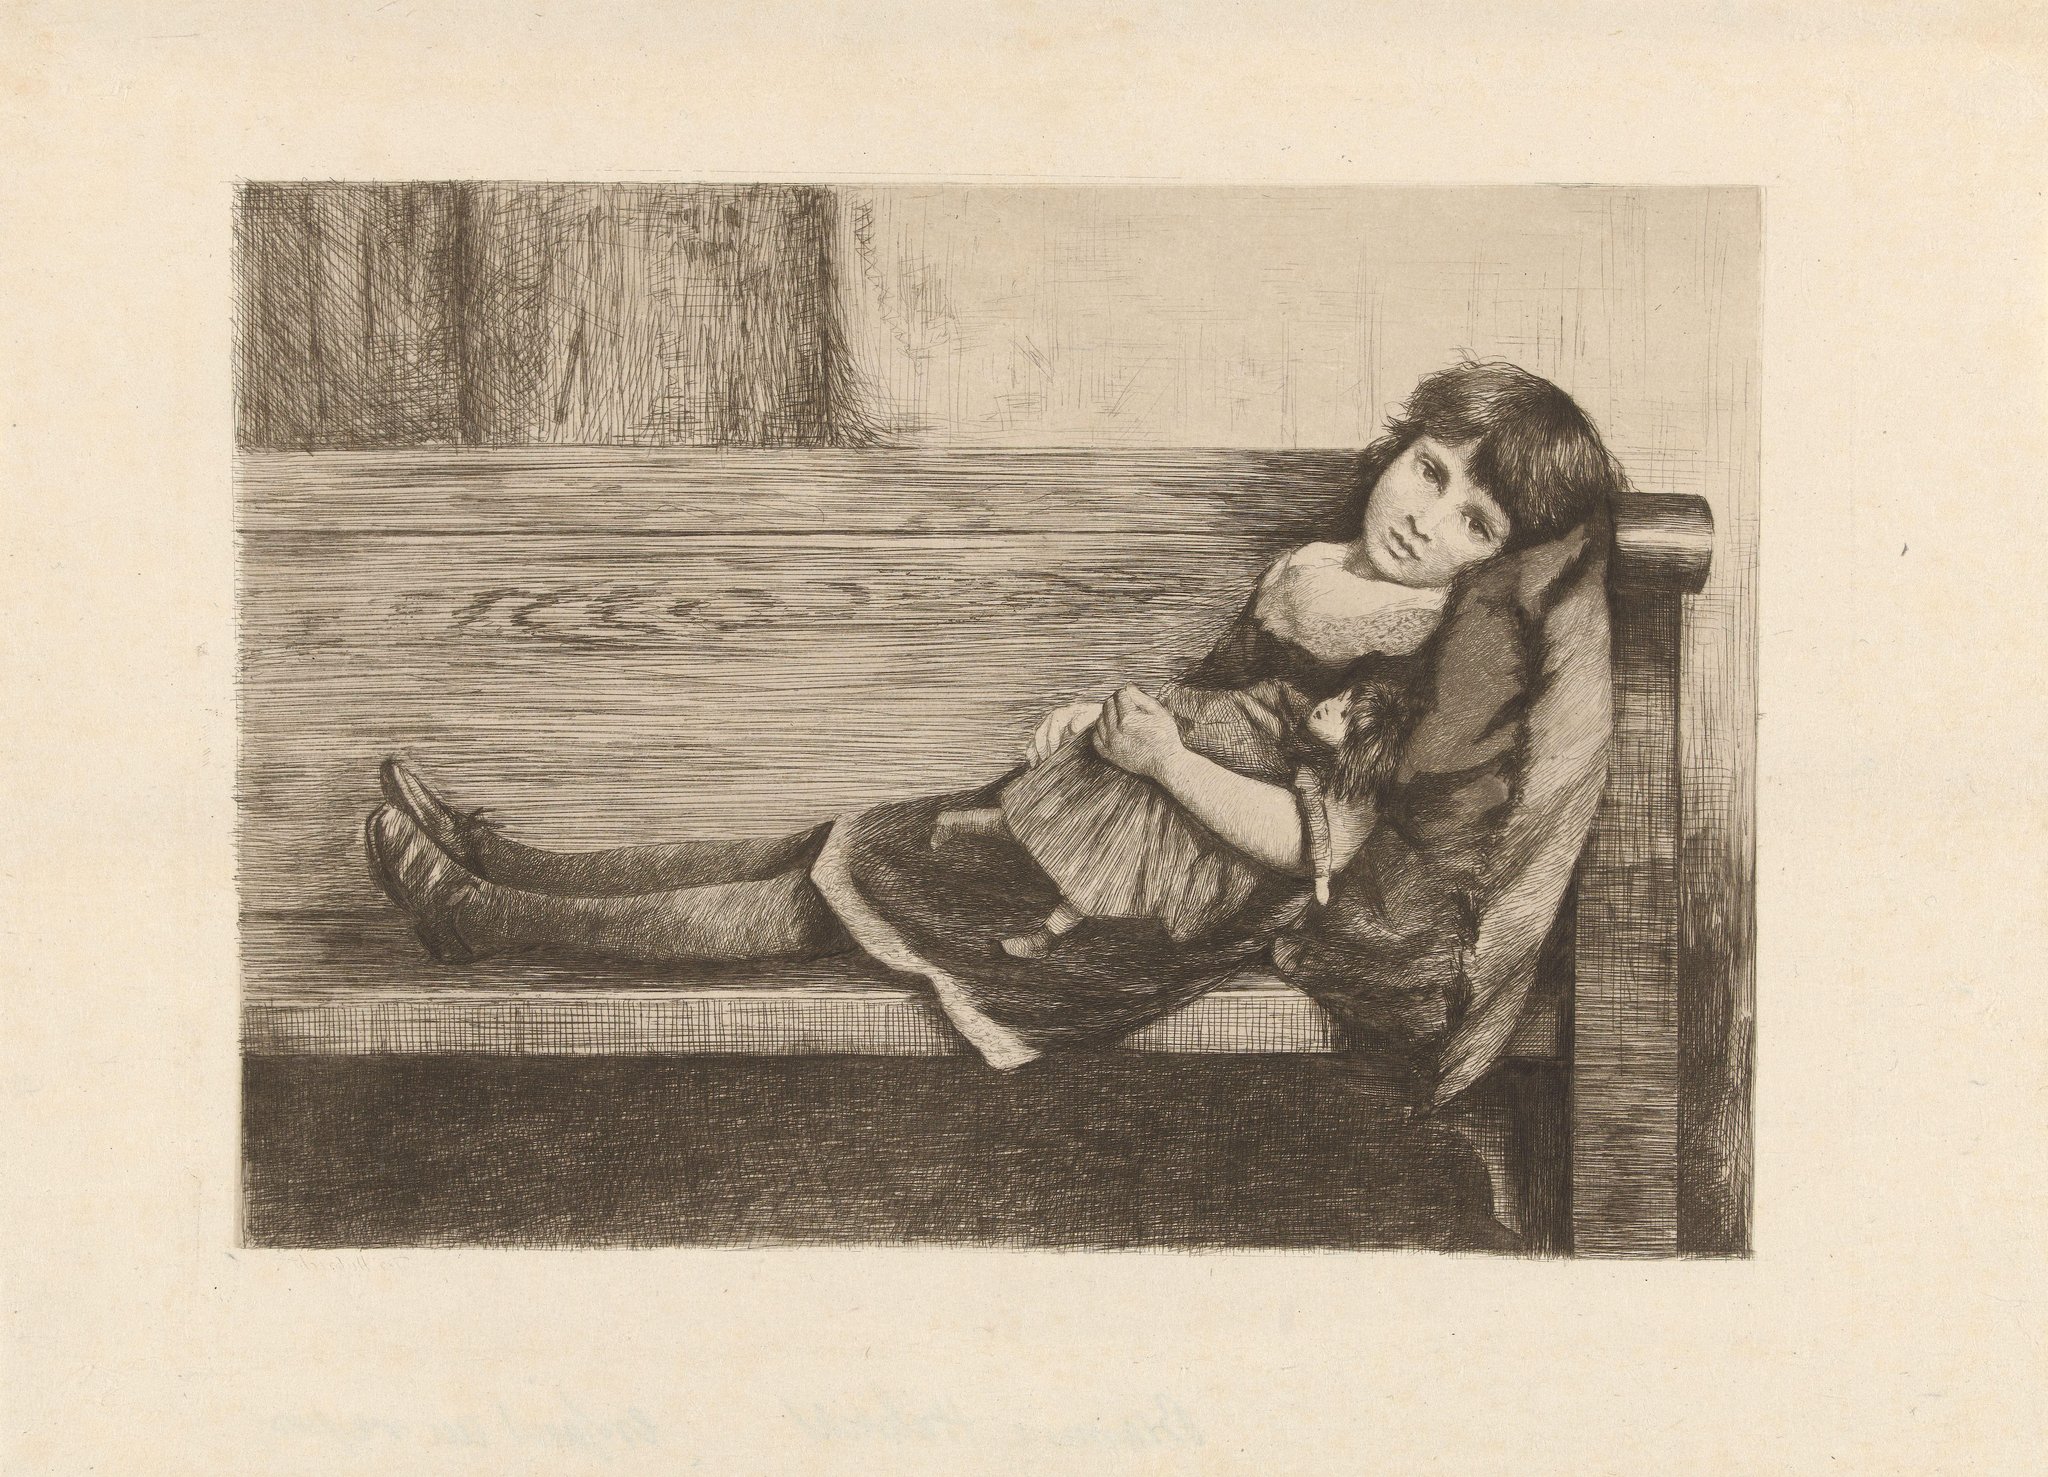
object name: print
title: Rustend kind met pop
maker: a.a.l. de grammont-hubrecht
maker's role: draughtsman, painter, print maker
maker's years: 1855-1913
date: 1870-1910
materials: paper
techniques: etching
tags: (playing with) dolls, child (at home)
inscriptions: collector's mark: Lugt 2228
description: Op een houten bank leunt een kind halfliggend tegen een kussen en de armleuning aan, met een pop in de arm.